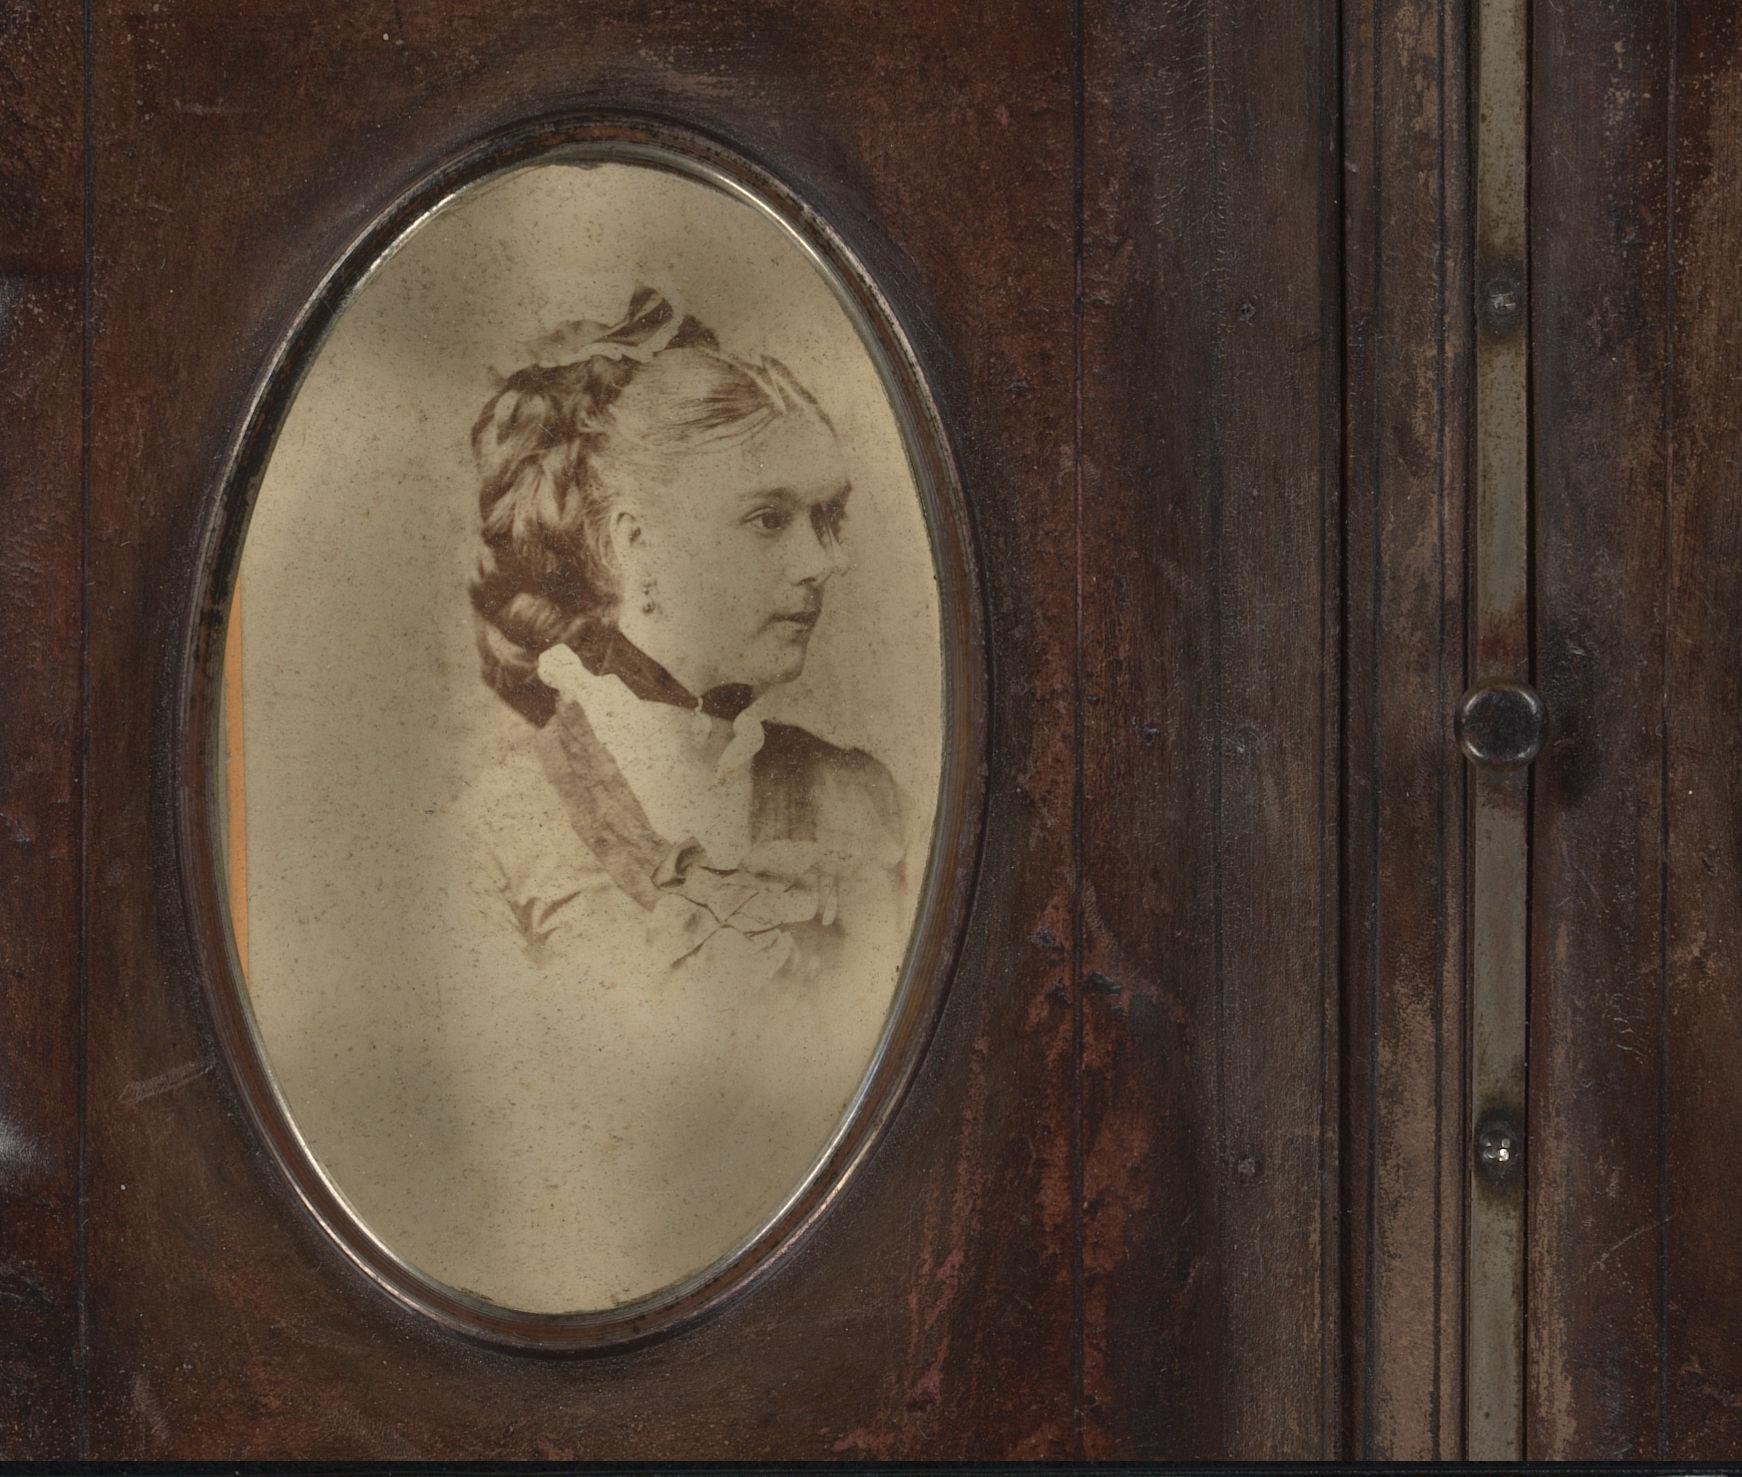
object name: carte de visite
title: Portret van een jonge vrouw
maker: Anonymous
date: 1870-1880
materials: cardboard, photographic support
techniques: albumen print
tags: adolescent, young woman, maiden, historical persons - bb - woman